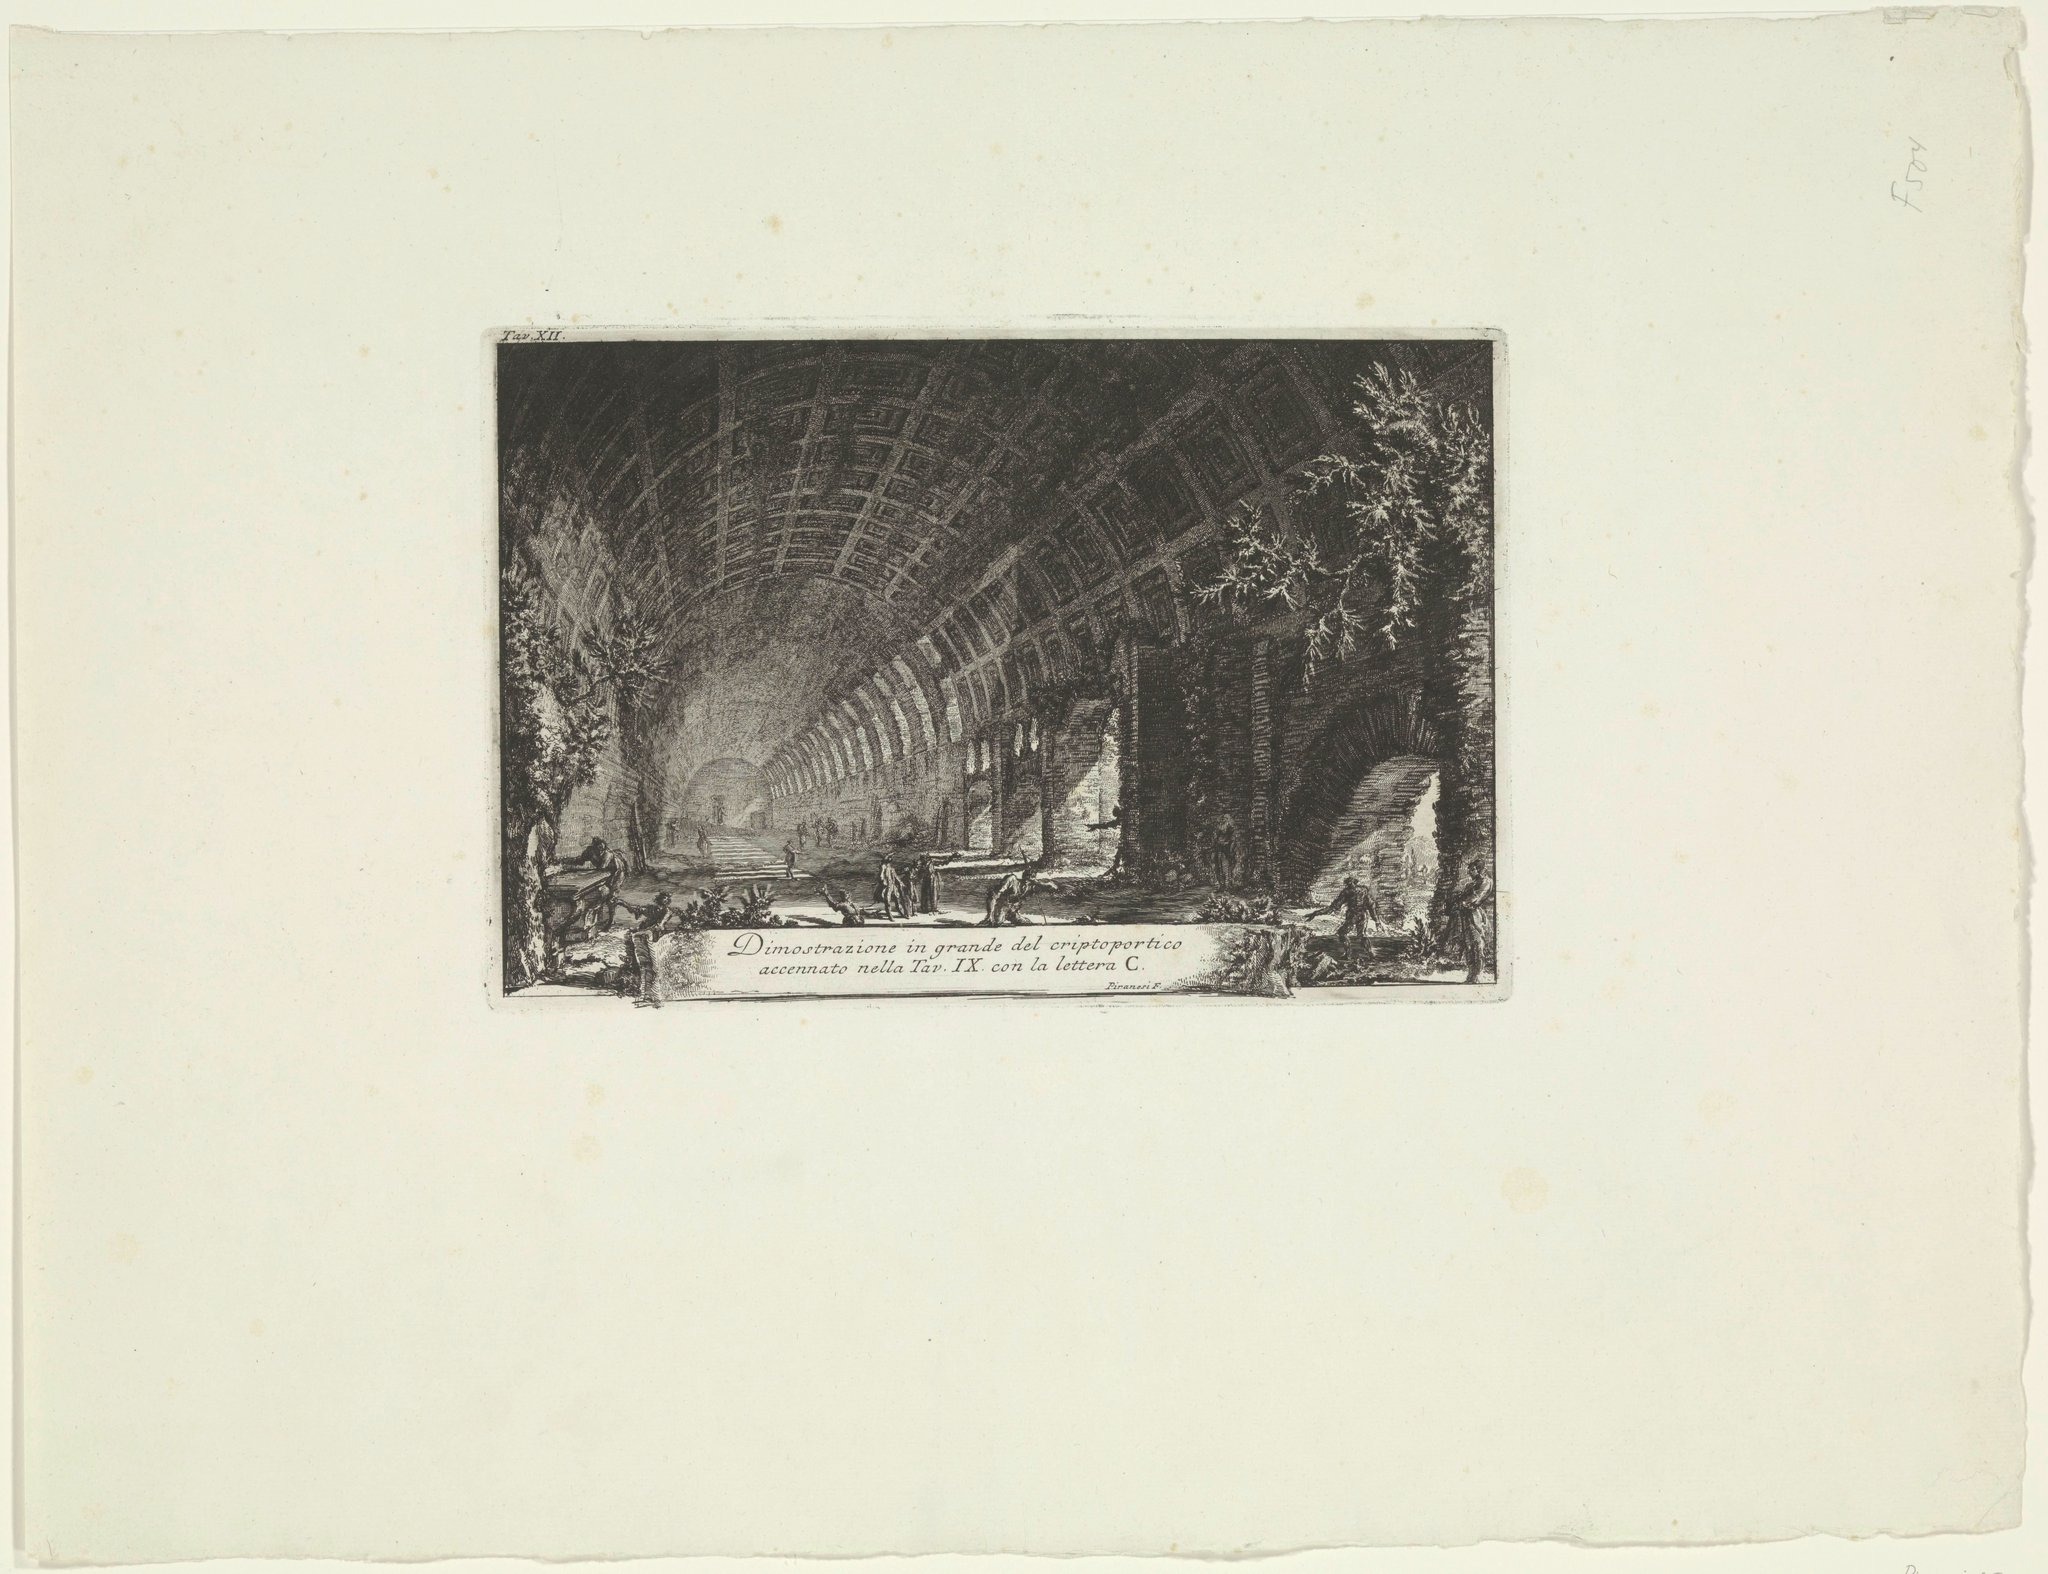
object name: print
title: Twee versierde grotten bij het Meer van Albano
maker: giovanni battista piranesi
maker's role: designer, draughtsman, print maker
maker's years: 1720-1778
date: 1762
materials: paper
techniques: etching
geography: rome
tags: ruin of a building ~ architecture, gallery (spacious corridor)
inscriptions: collector's mark: Lugt 2228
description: Gezicht in een cryptoporticus (overdekte galerij) met cassetteplafond. Volgens de titel die verwijst naar een andere prent uit dezelfde serie gaat het om de funderingen van de Villa van Clodio in de Albaanse Heuvels, later in bezit van de familie Barberini. Titel midden onder. Genummerd linksboven: Tav. XII.